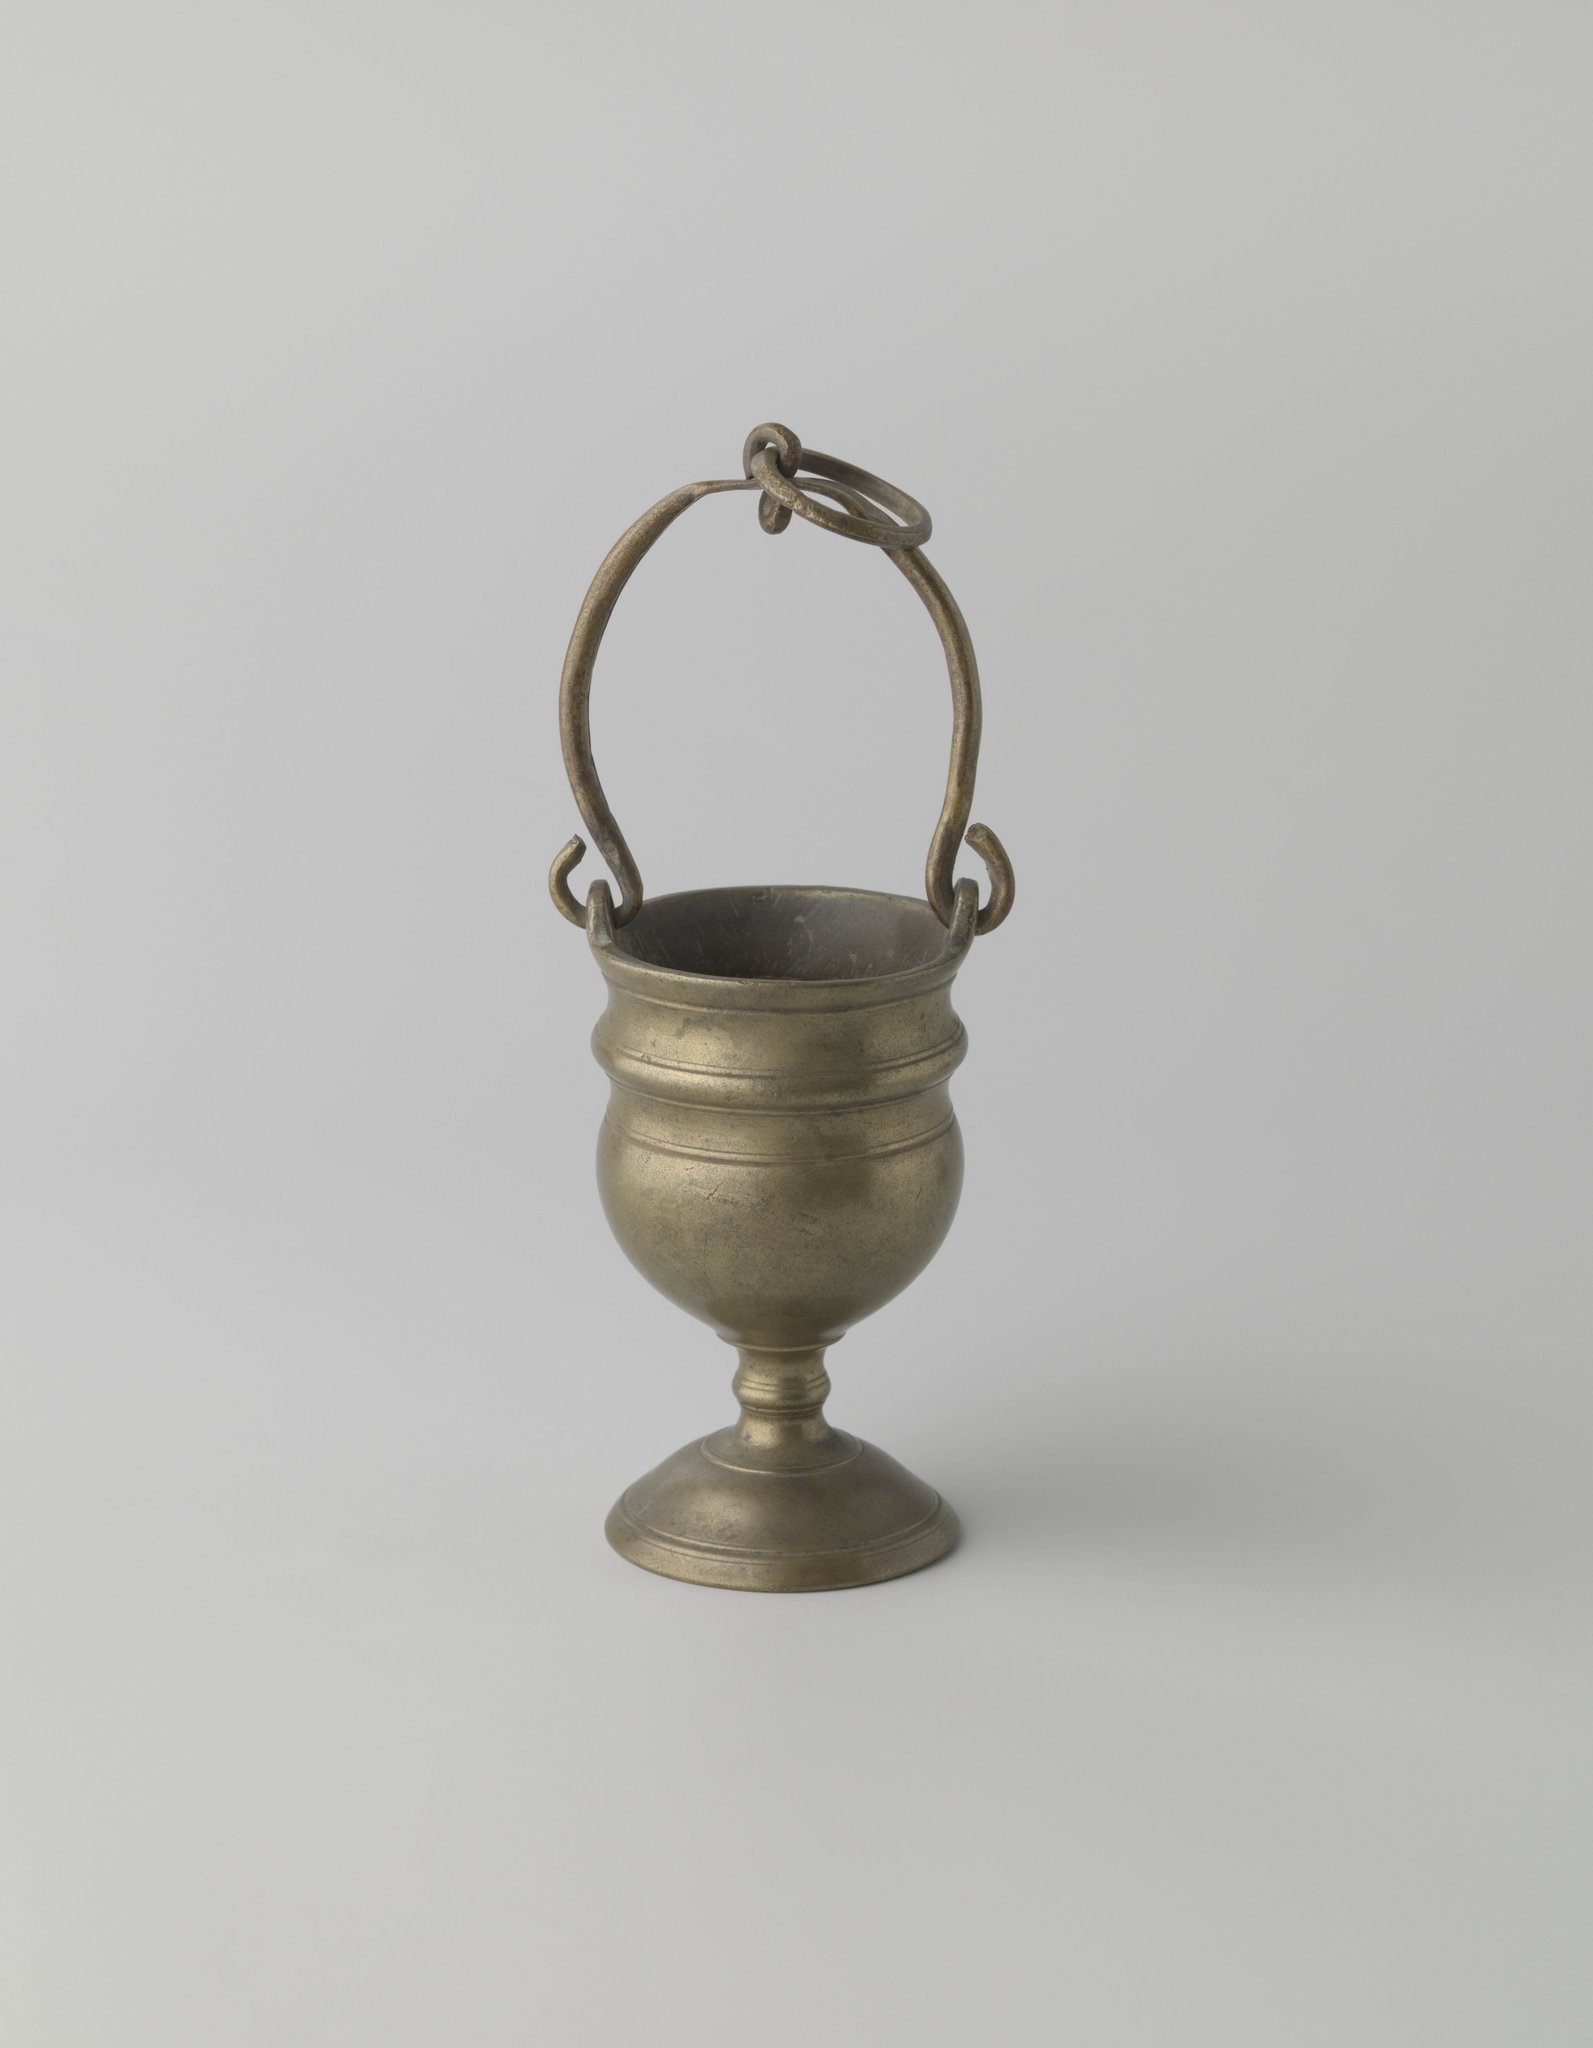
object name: aspersorium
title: Wijwateremmer, rond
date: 1600-1699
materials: brass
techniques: casting, striking, turning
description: Het voorwerp is samengesteld uit de volgende delen: de emmer (gegoten en afgedraaid), het hengsel, het haakje en het oog (geslagen). De ronde emmer heeft onderaan een dunne schacht, welke overgaat in een ronde naar buiten toe aflopende holle voet (met centergat aan de onderkant). De schacht is twee maal holrond geprofileerd met een bolle rib in het midden. Een dergelijke profilering doet zich ook voor bij de bovenkant van de emmer. Het hengsel met de overige onderdelen is vernieuwd.